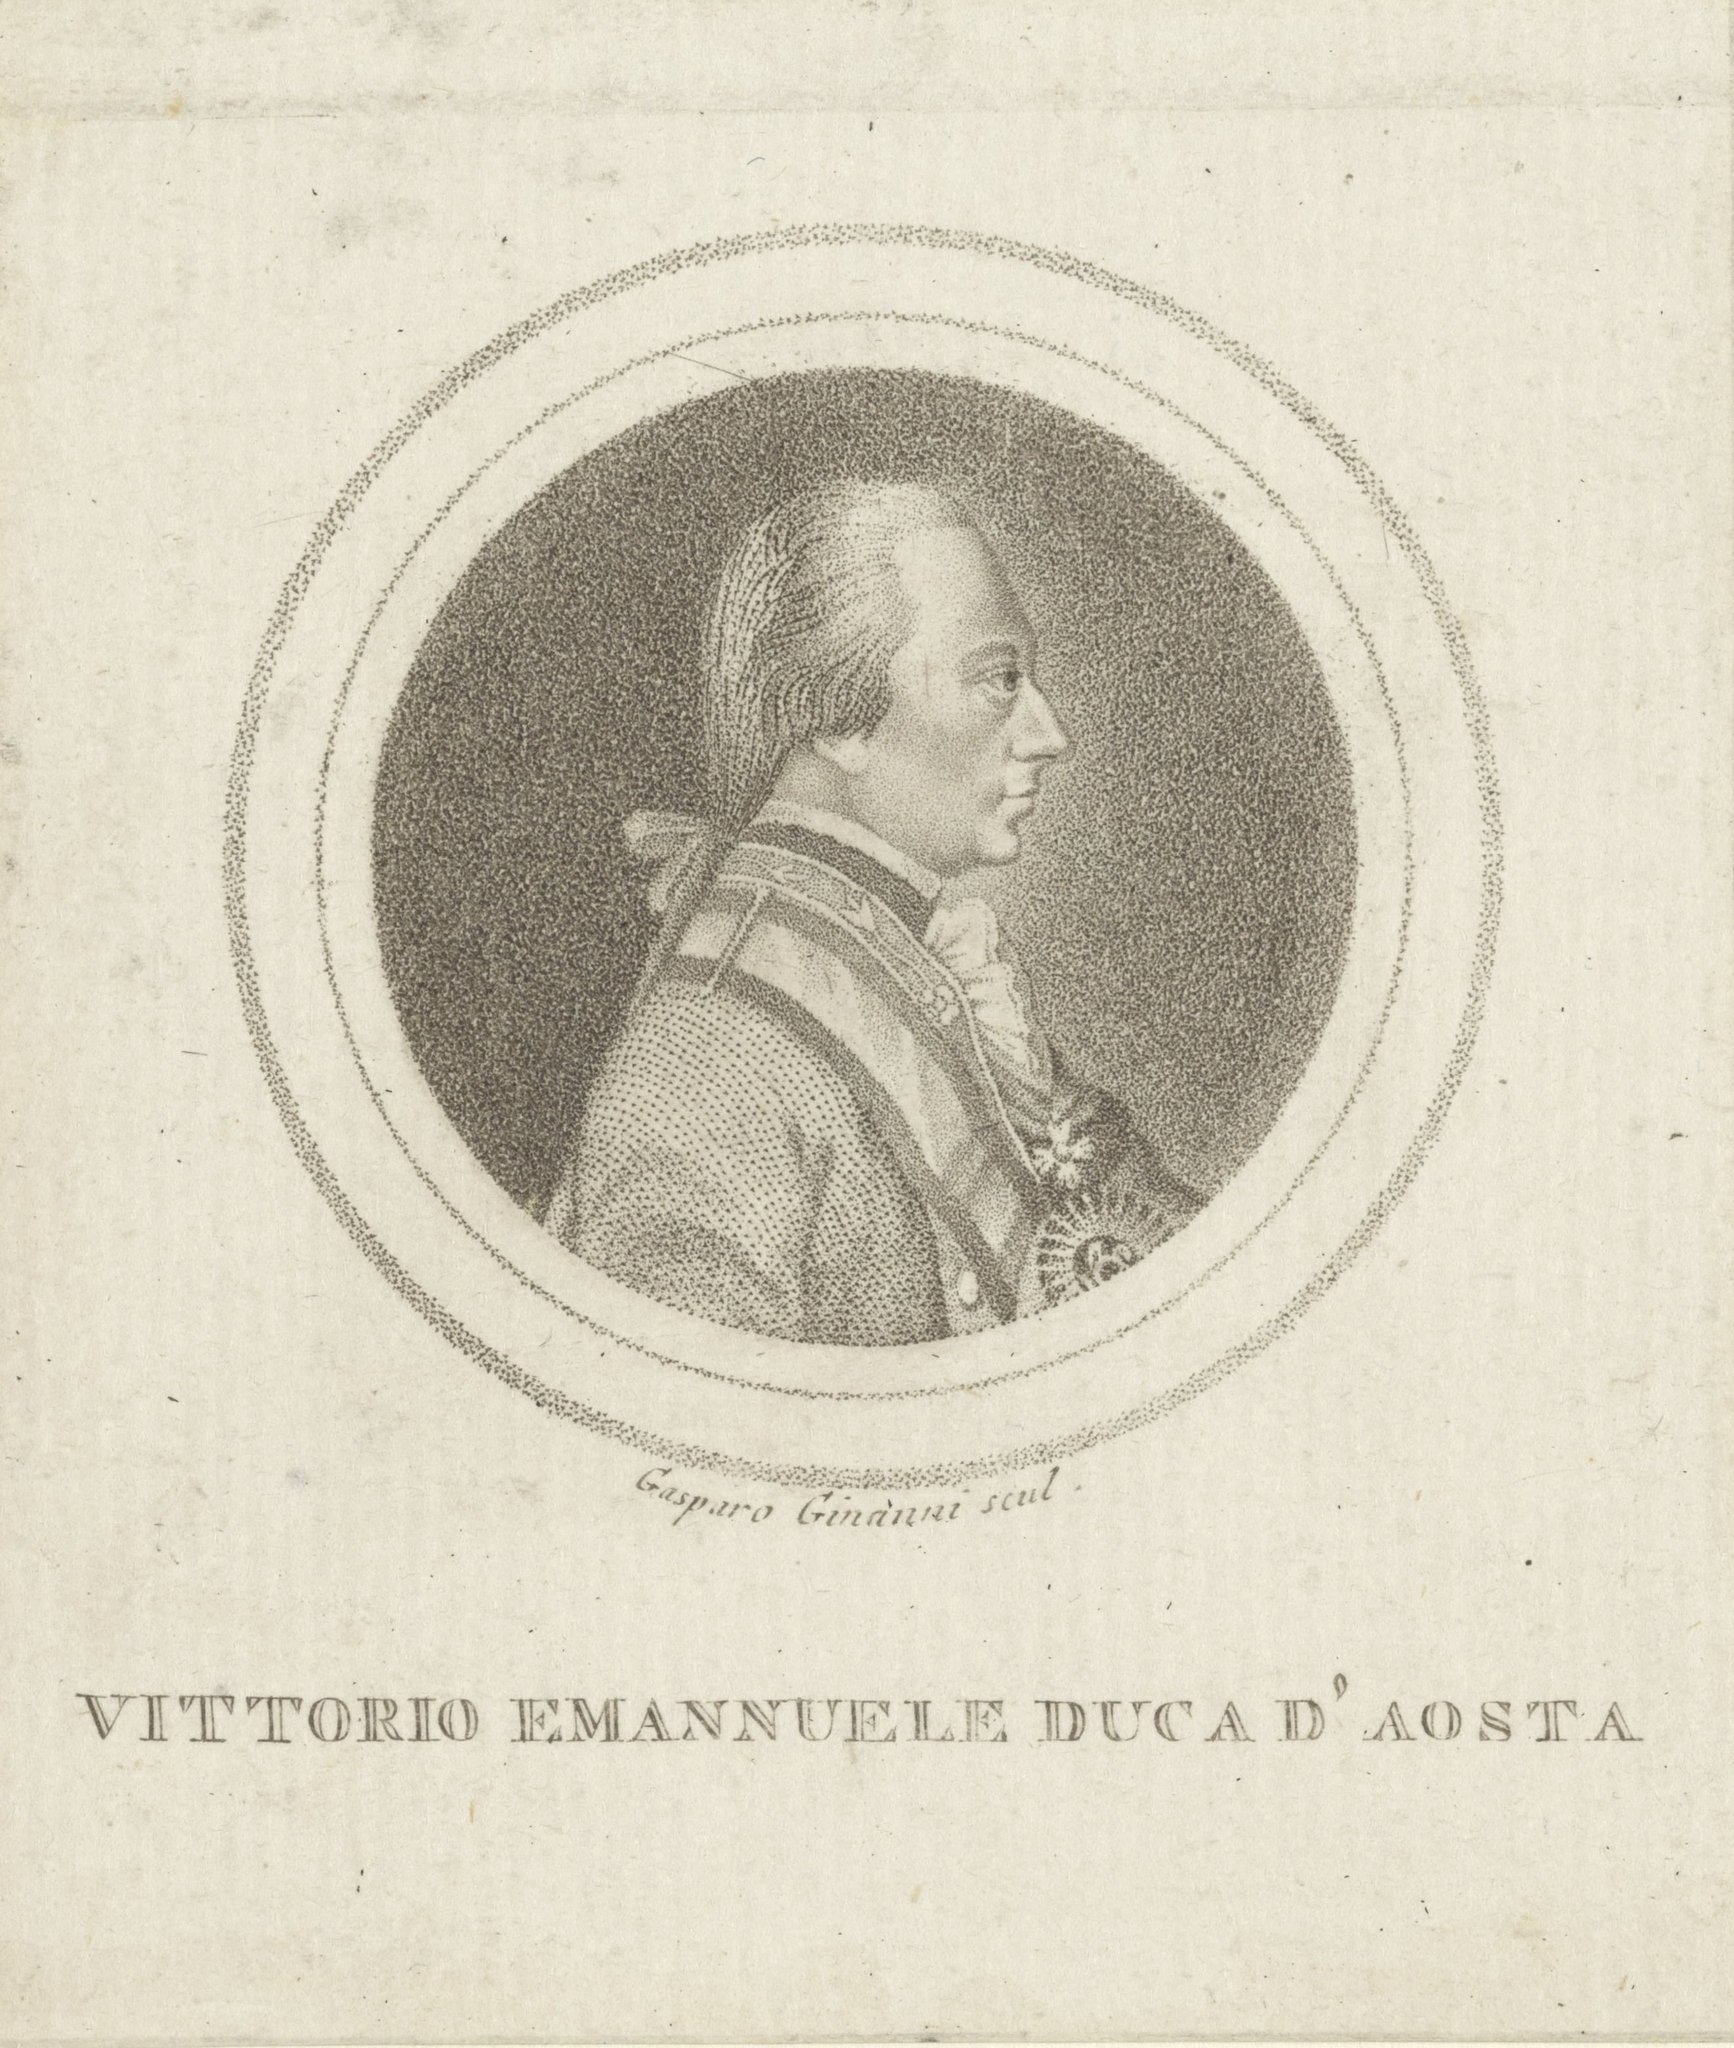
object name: print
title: Portret van Vittorio Emanuele I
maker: gaspare ginanni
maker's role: print maker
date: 1791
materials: paper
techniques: stippling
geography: italy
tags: historical persons, ruler, sovereign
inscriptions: collector's mark: Lugt 2228